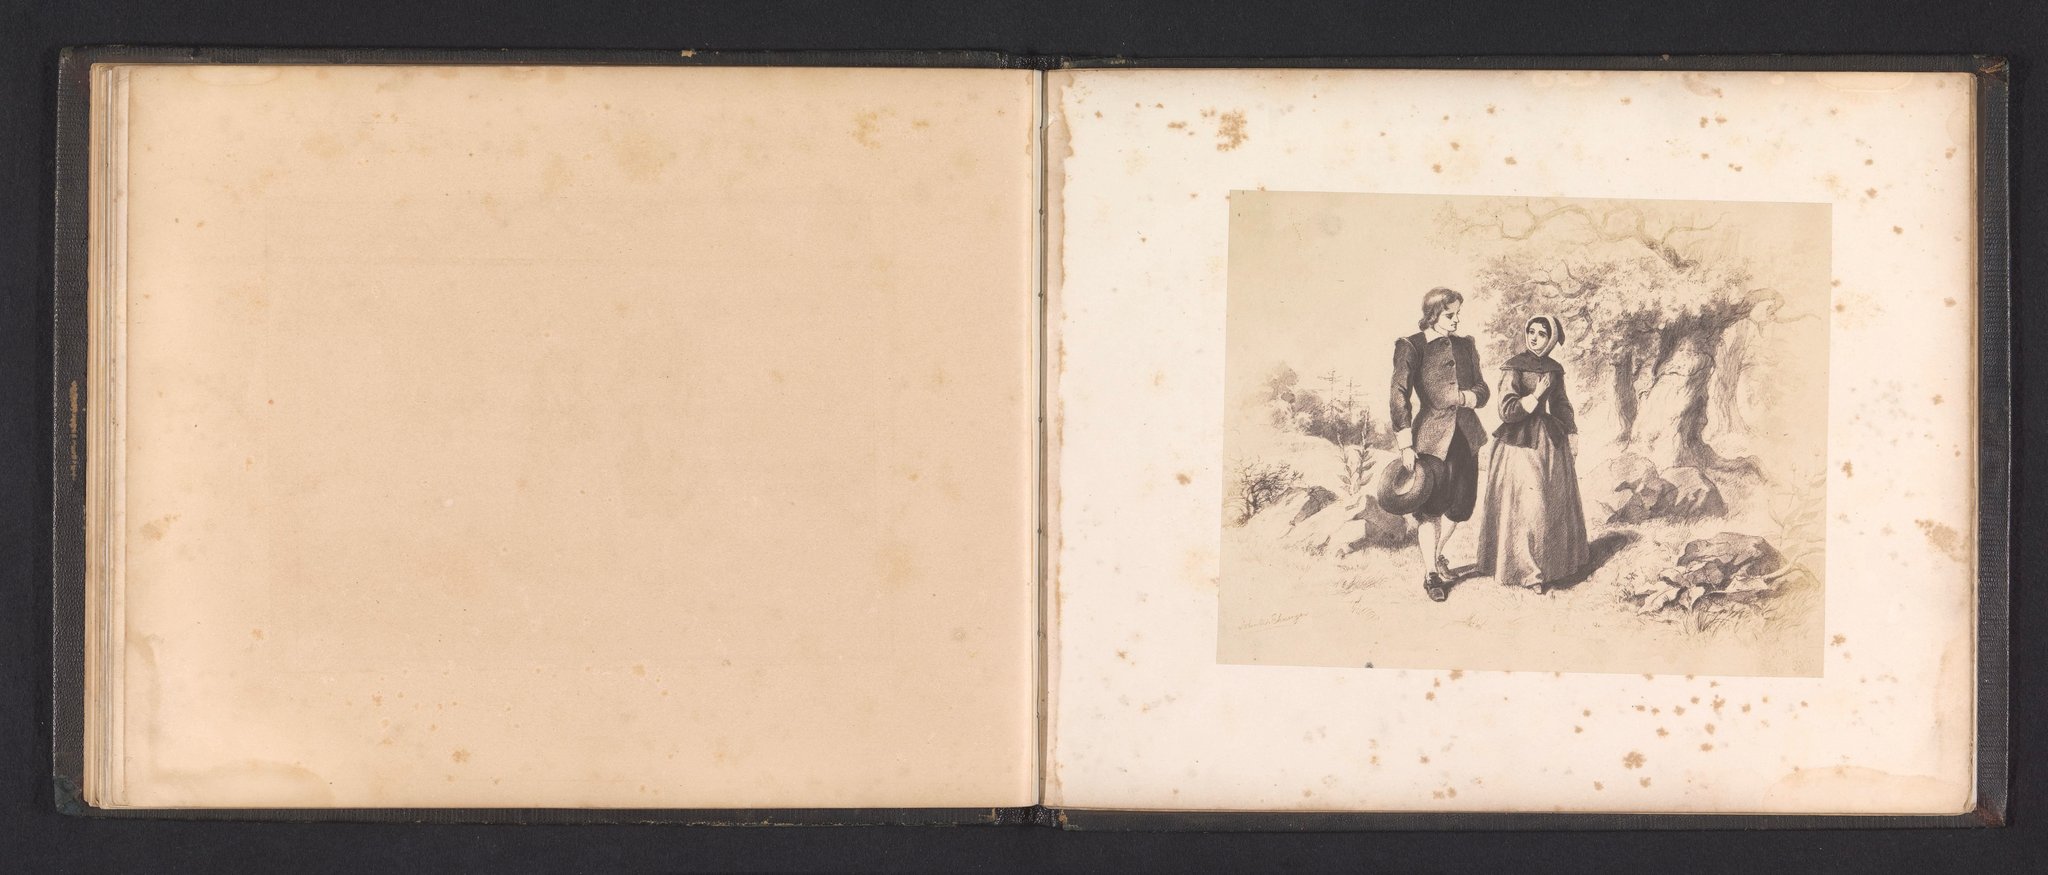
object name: photograph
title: Fotoreproductie van een tekening, voorstellende John Alden en Priscilla Mullins lopen een bos in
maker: mathew benjamin brady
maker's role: fotograaf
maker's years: 1823-1896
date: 1854-1859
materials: photographic support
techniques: salted paper print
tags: pilgrim(s), lovers' meeting